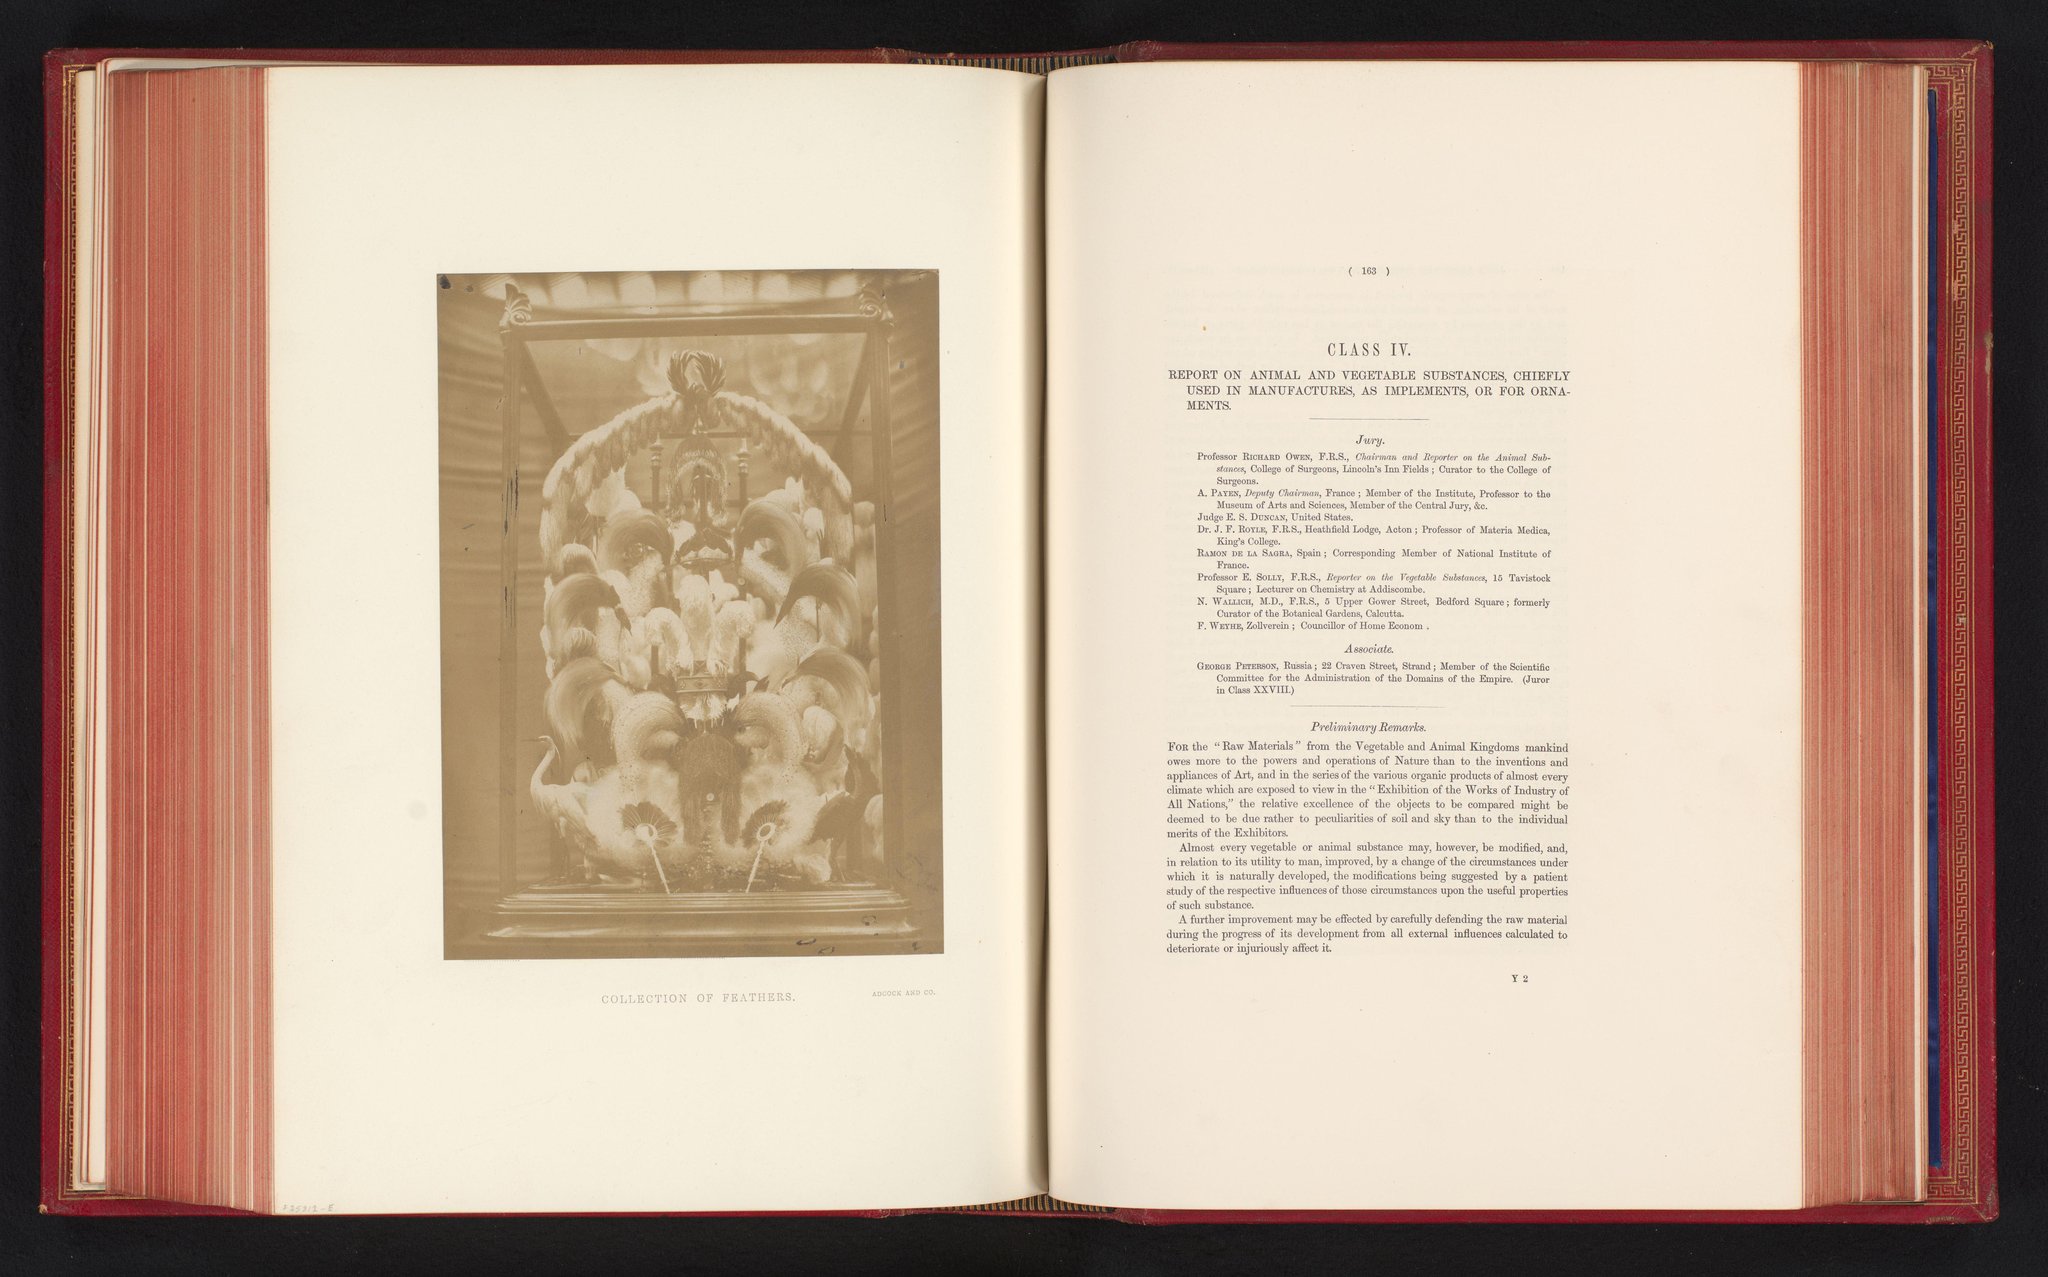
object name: page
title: Collection of Feathers. Adcock and Co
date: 1851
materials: photographic support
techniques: salted paper print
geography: crystal palace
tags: shop-window, show-window